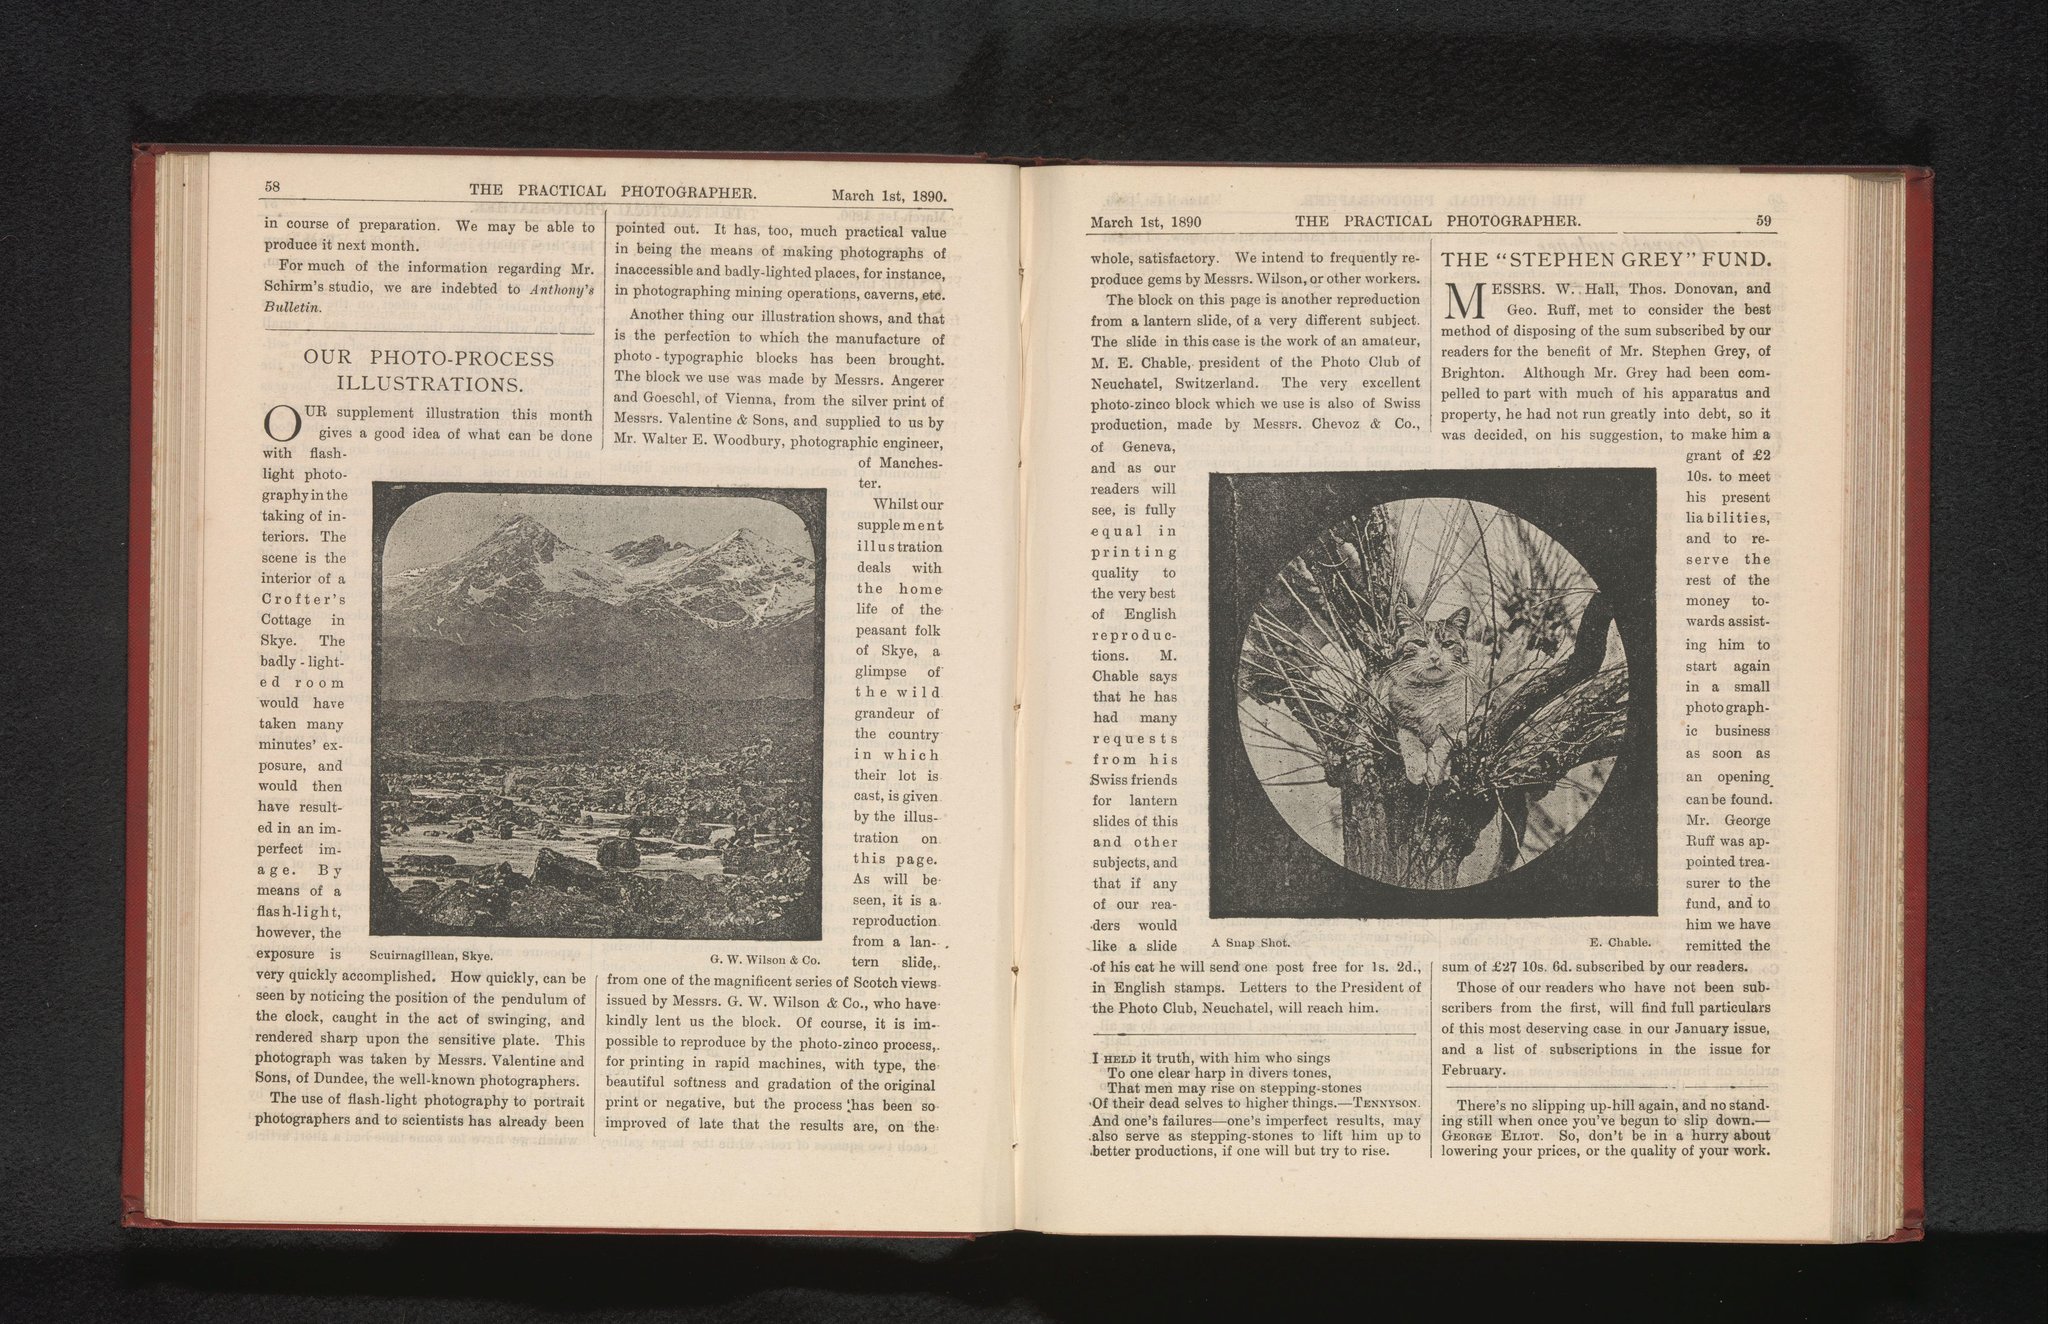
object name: page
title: Scurinagillean, Skye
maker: george washington wilson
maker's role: publisher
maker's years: 1823-1893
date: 1885-1890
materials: paper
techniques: autotype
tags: mountains